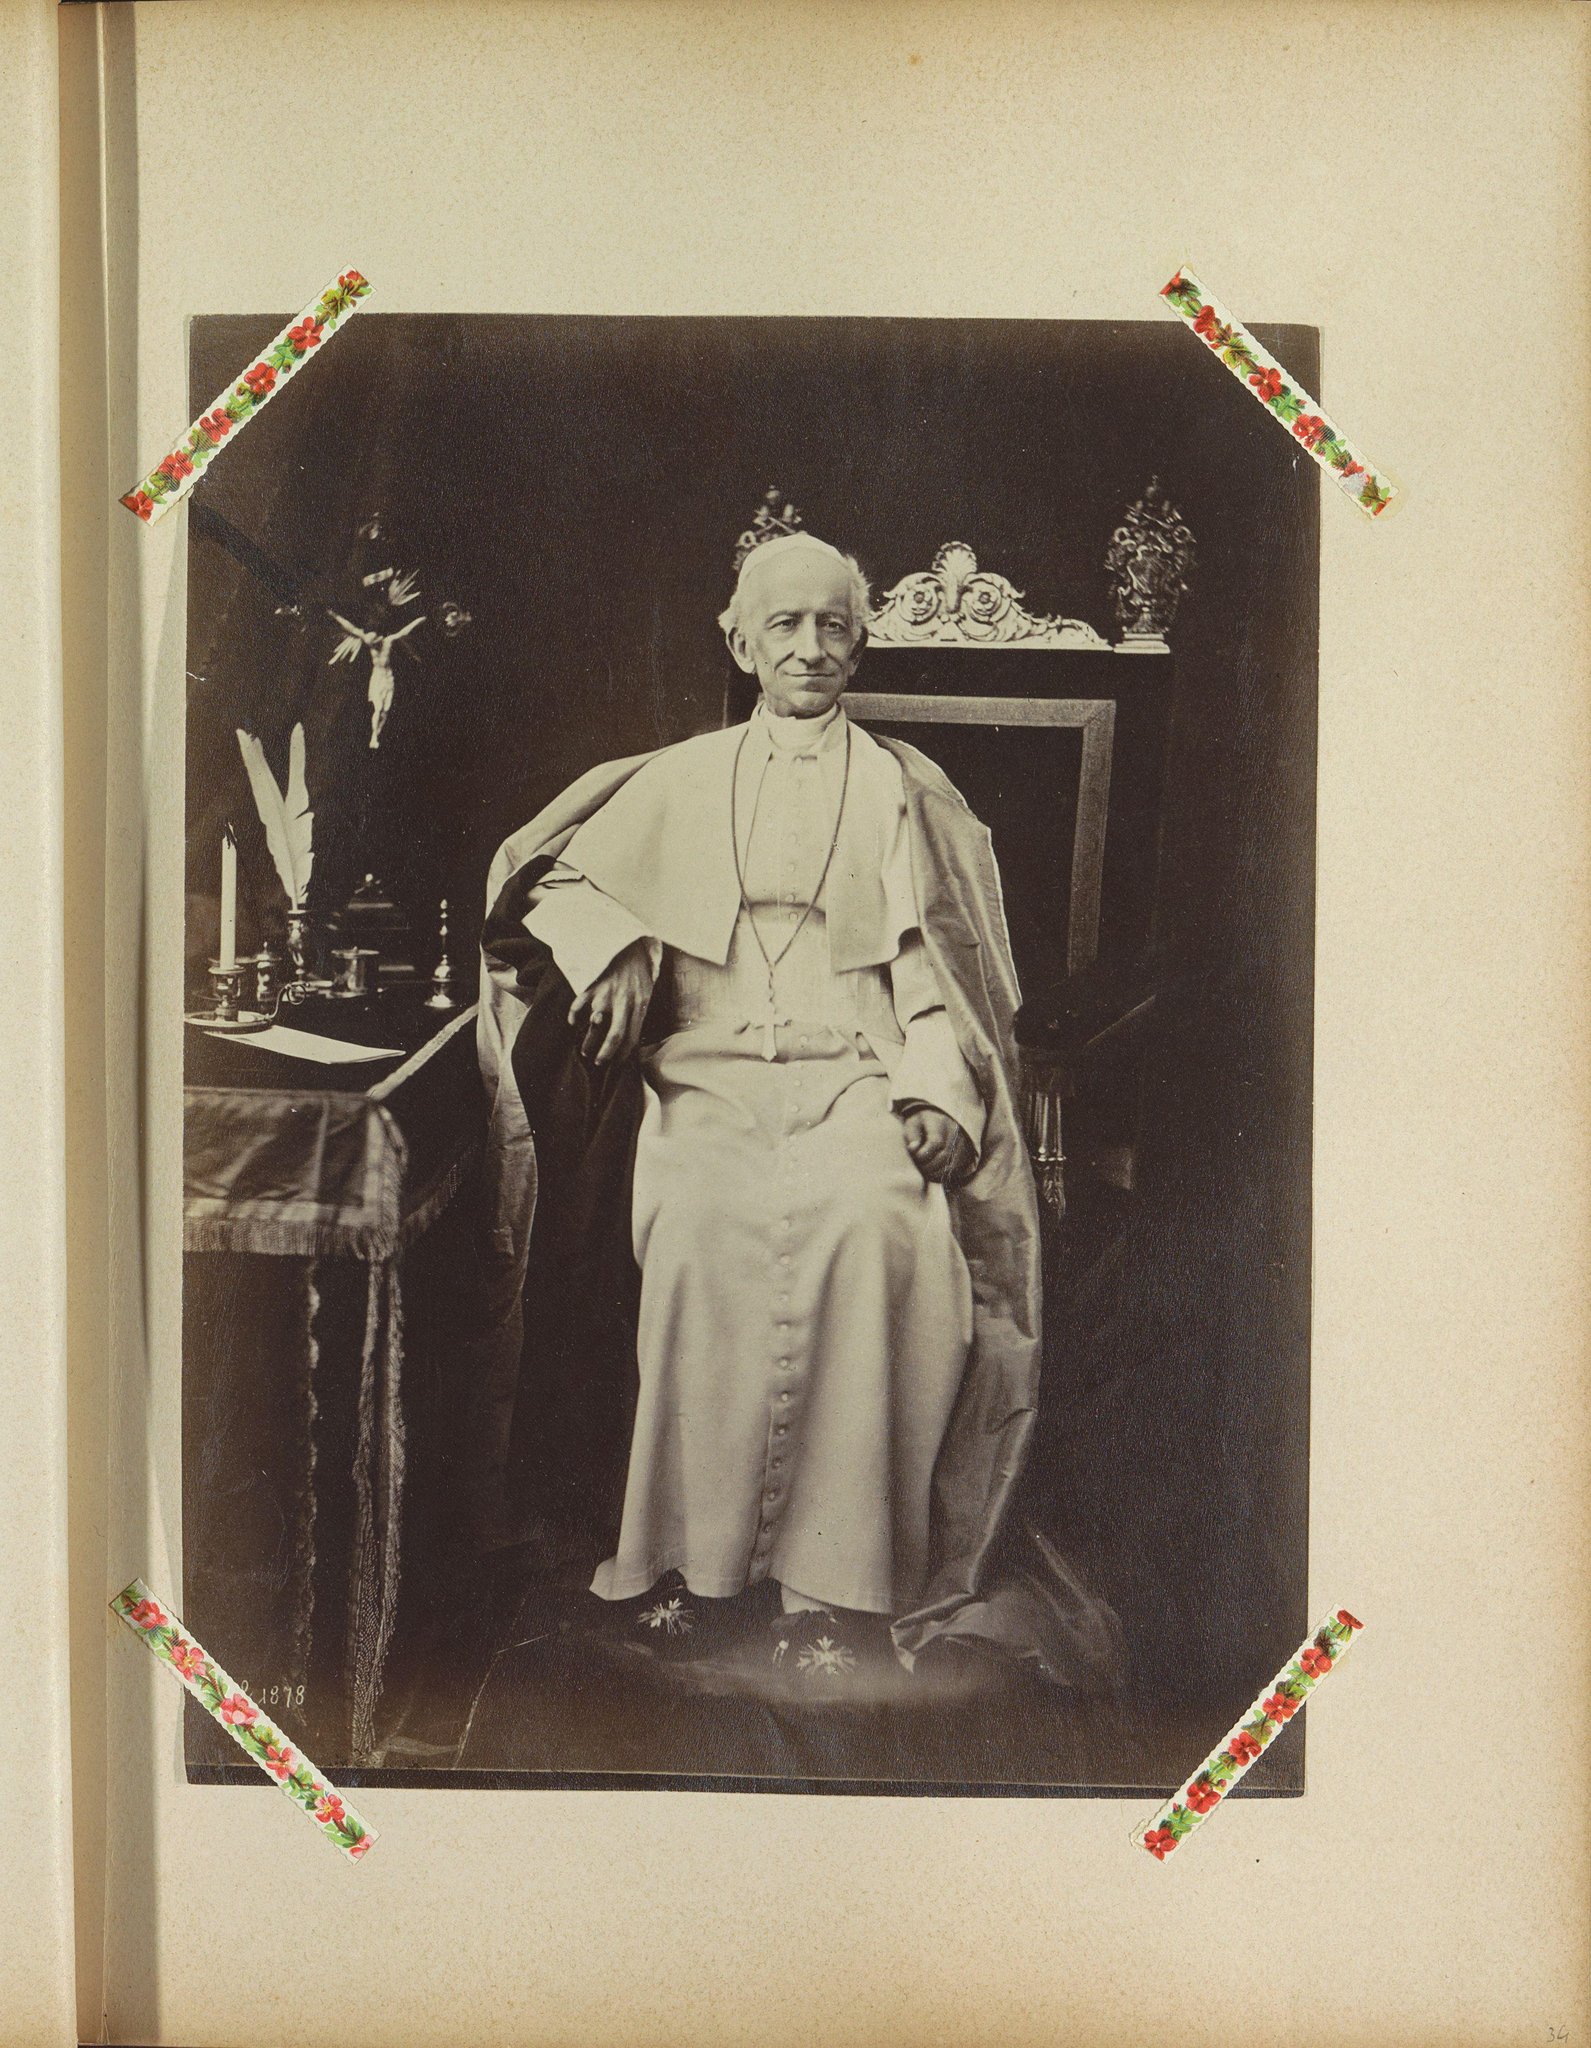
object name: photograph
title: Portret van paus Leo XIII, zittend, van voor gezien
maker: Anonymous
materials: photographic support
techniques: albumen print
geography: italy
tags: rome, leo xiii, pope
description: Onderdeel van Fotoalbum met opnames van bezienswaardigheden in Italiaanse steden en van kunstwerken.